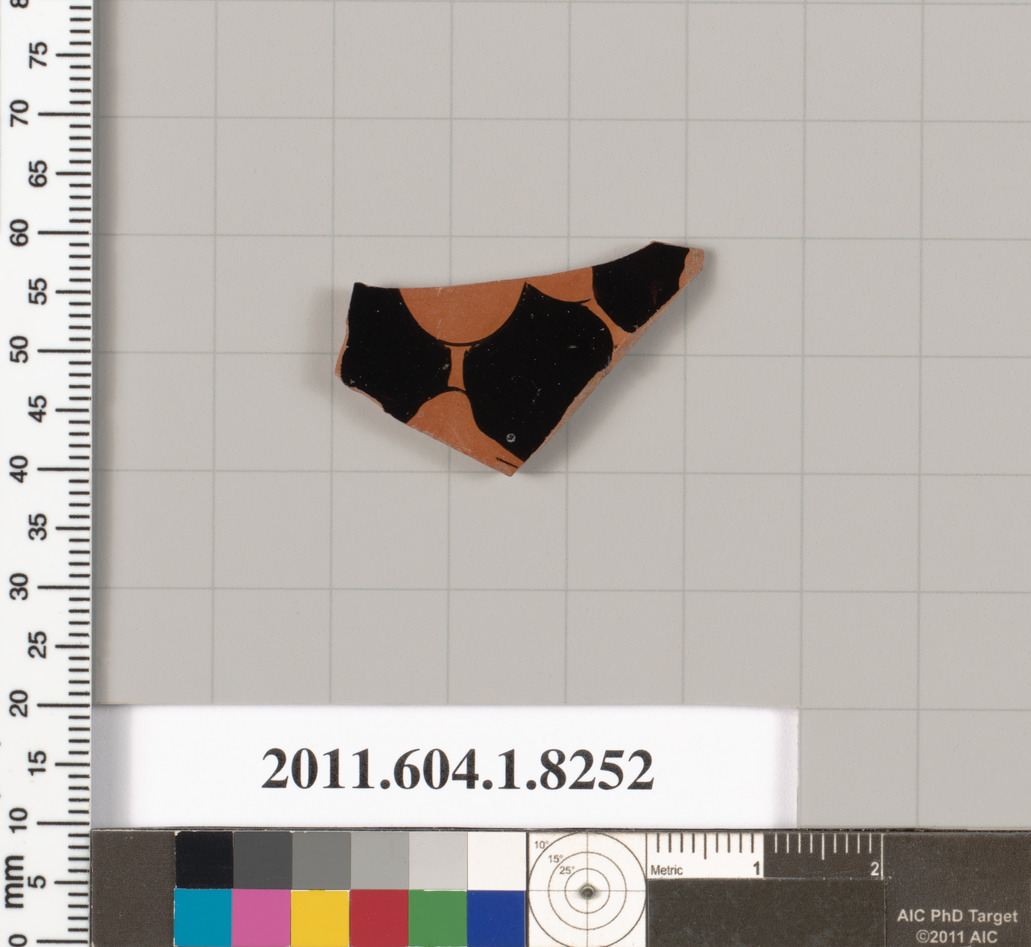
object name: kylix fragment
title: Terracotta fragment of a kylix (drinking cup)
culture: greek, attic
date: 520-510 BCE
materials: terracotta